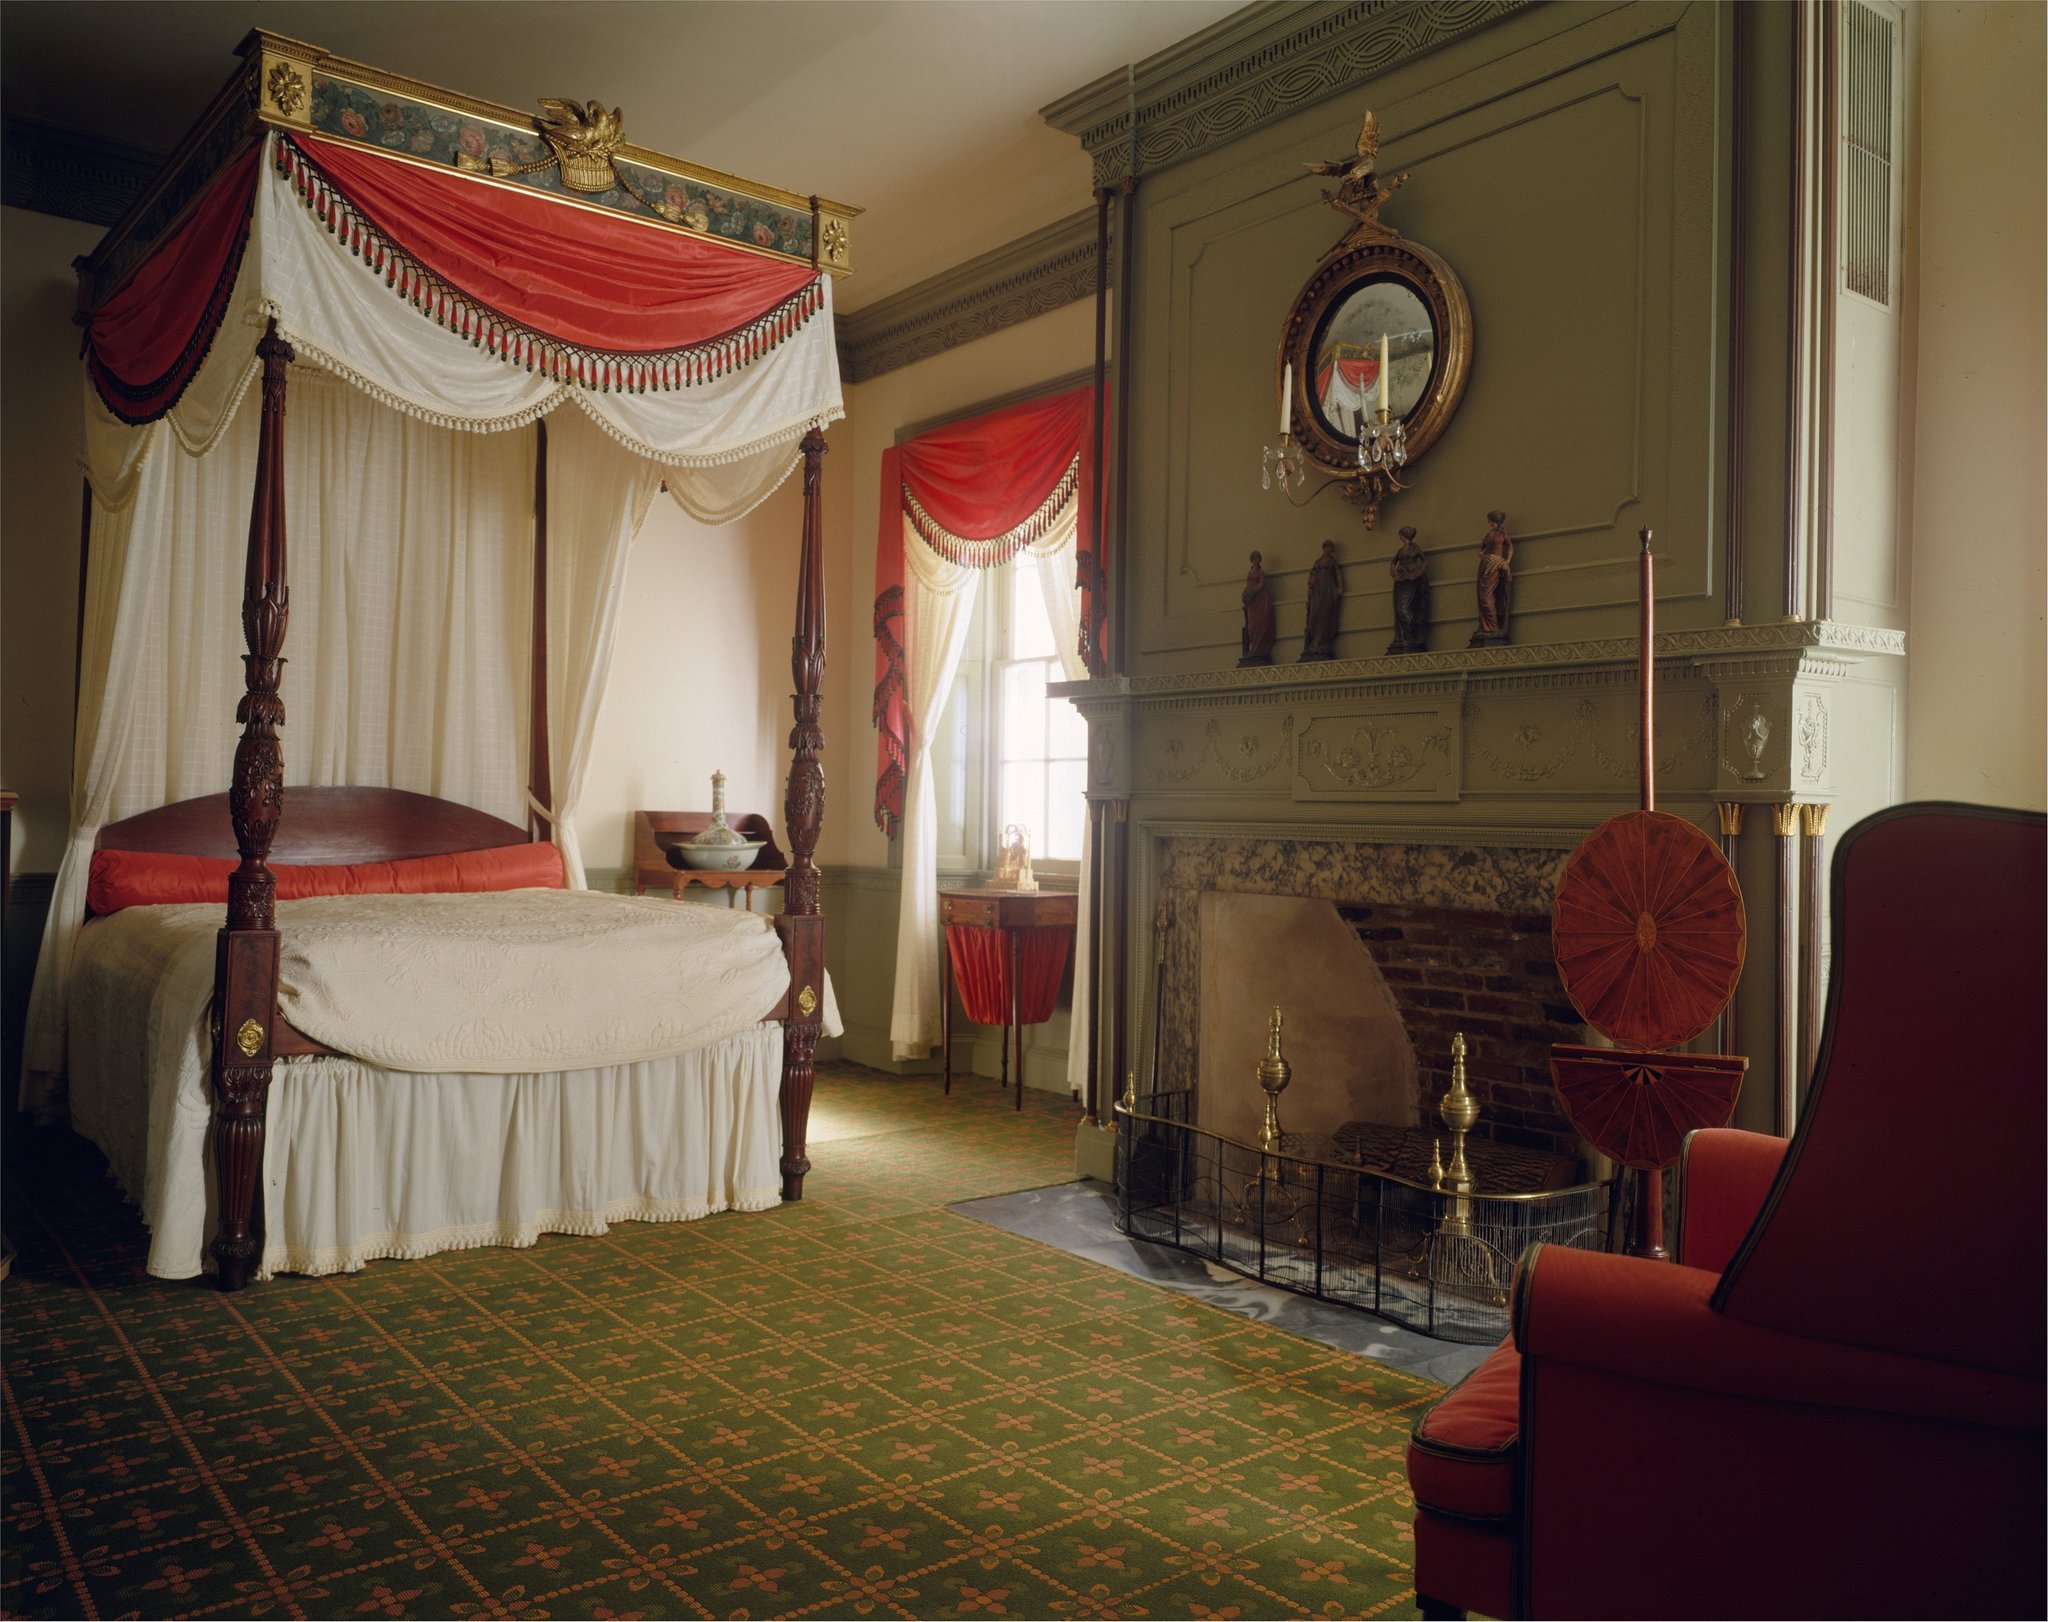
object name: parlor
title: Parlor from the James Duncan Jr. house, Haverhill, Massachusetts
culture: american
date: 1805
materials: wood, plaster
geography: united states